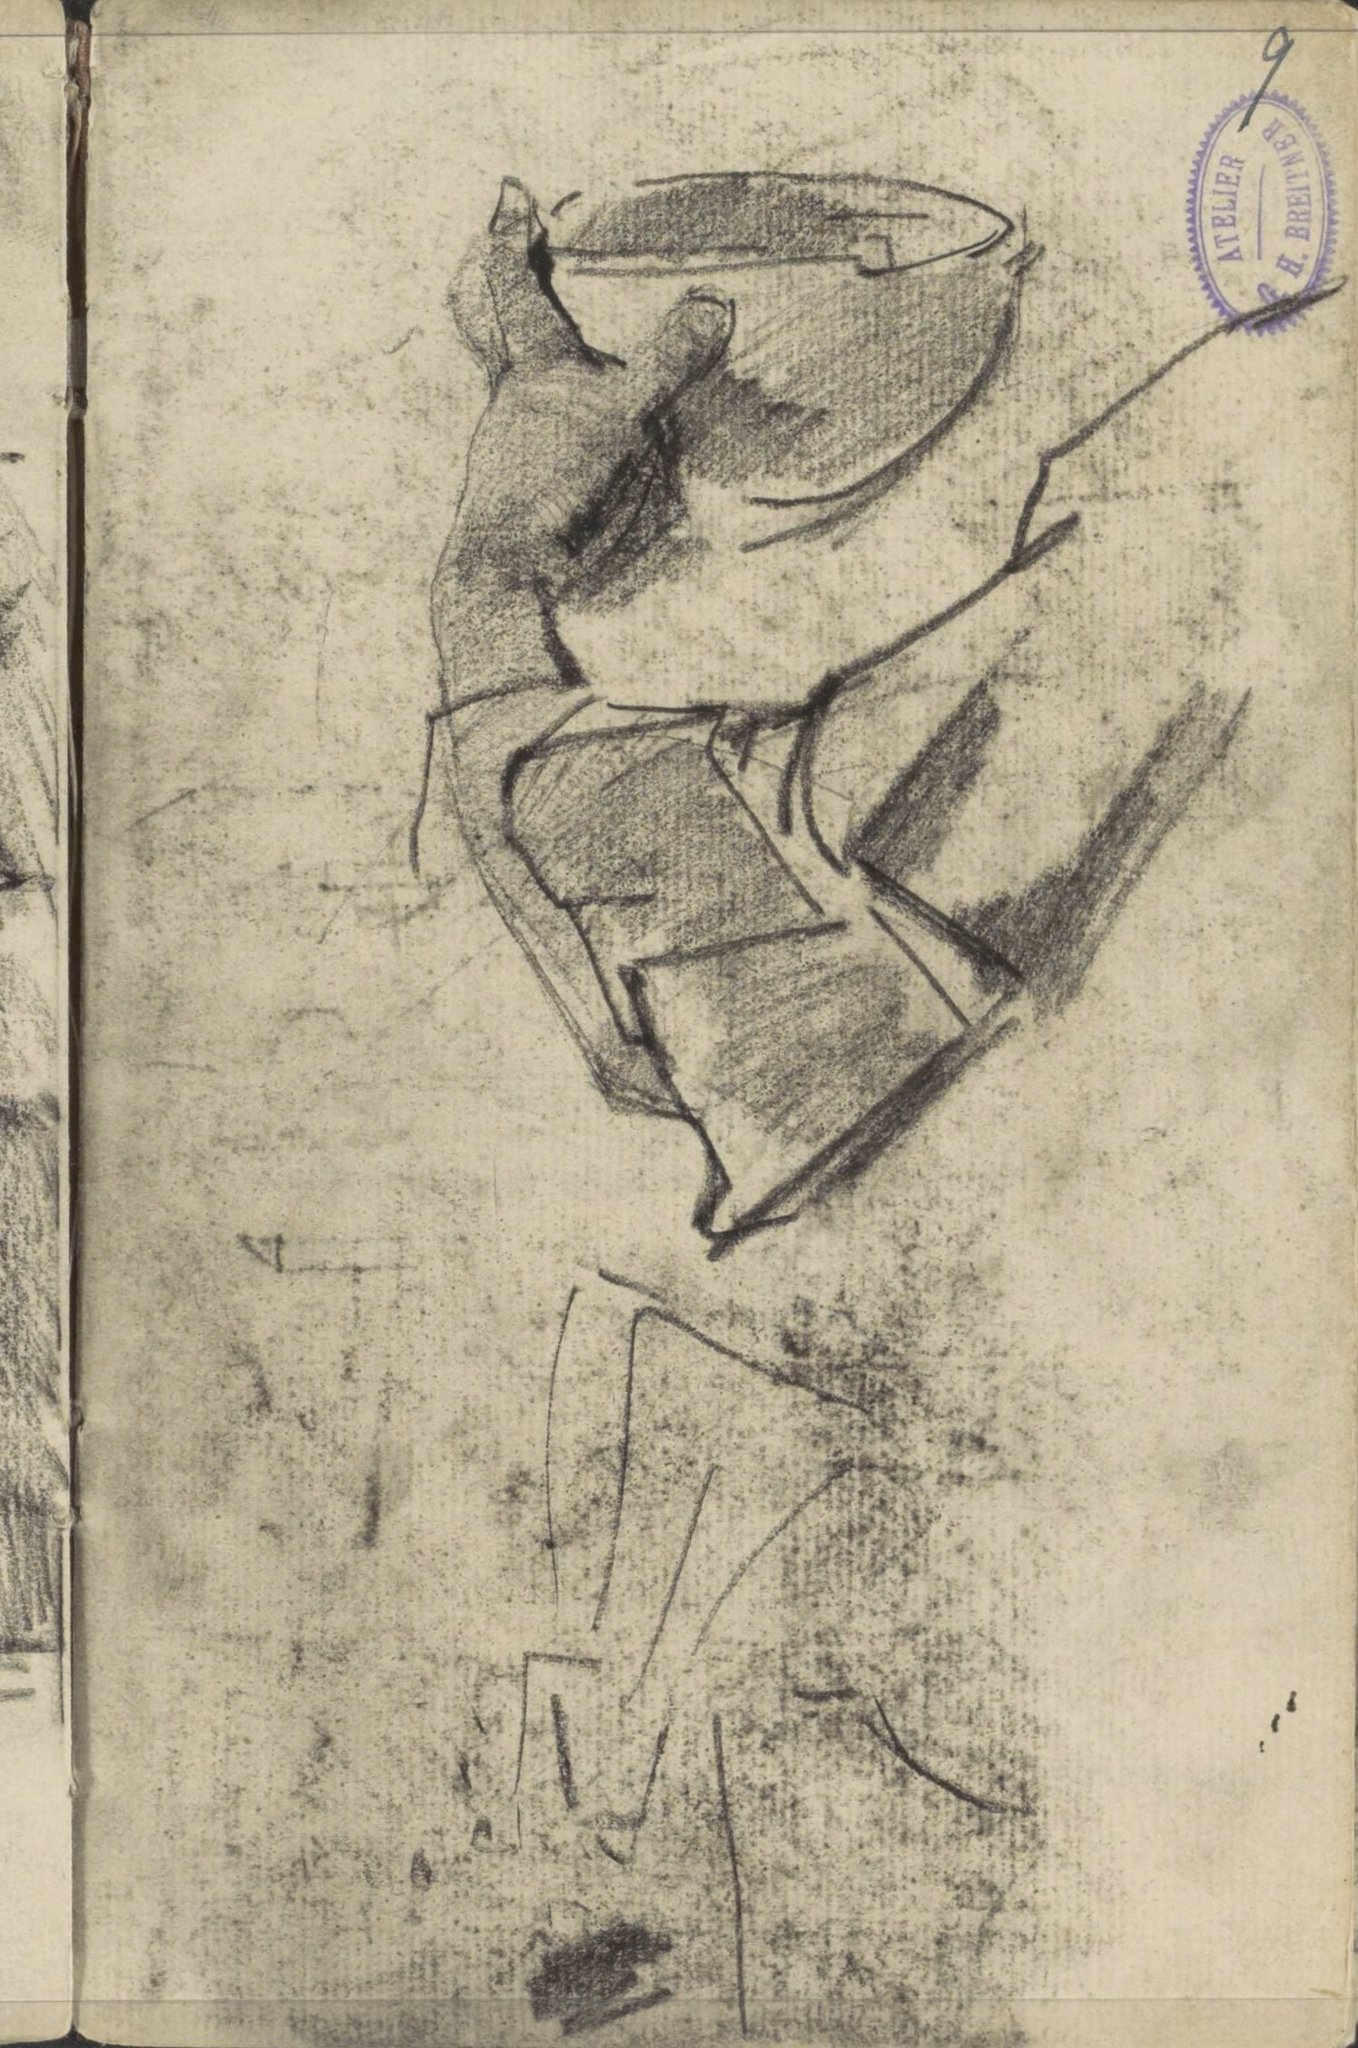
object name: sketchbook leaf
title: Woman with a Hat and a Man’s Arm with a Drinking Bowl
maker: george hendrik breitner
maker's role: draughtsman, painter, print maker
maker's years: 1857-1923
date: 1881-1887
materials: chalk, paper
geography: the hague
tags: adult woman, arms, cup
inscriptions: workshop stamp: Lugt 291d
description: Breitner may have drawn this sketch during the Japanese evening at Pulchri Studio, the artists’ association in The Hague. As can be read on the poster elsewhere in this gallery, the programme included a Japanese tea ceremony. Here we see a detail of an arm (in a wide, turned-up sleeve) and a hand holding a tea bowl. Drawn – upside down – at the bottom of the sheet is a city girl: there is nothing Japanese about that.